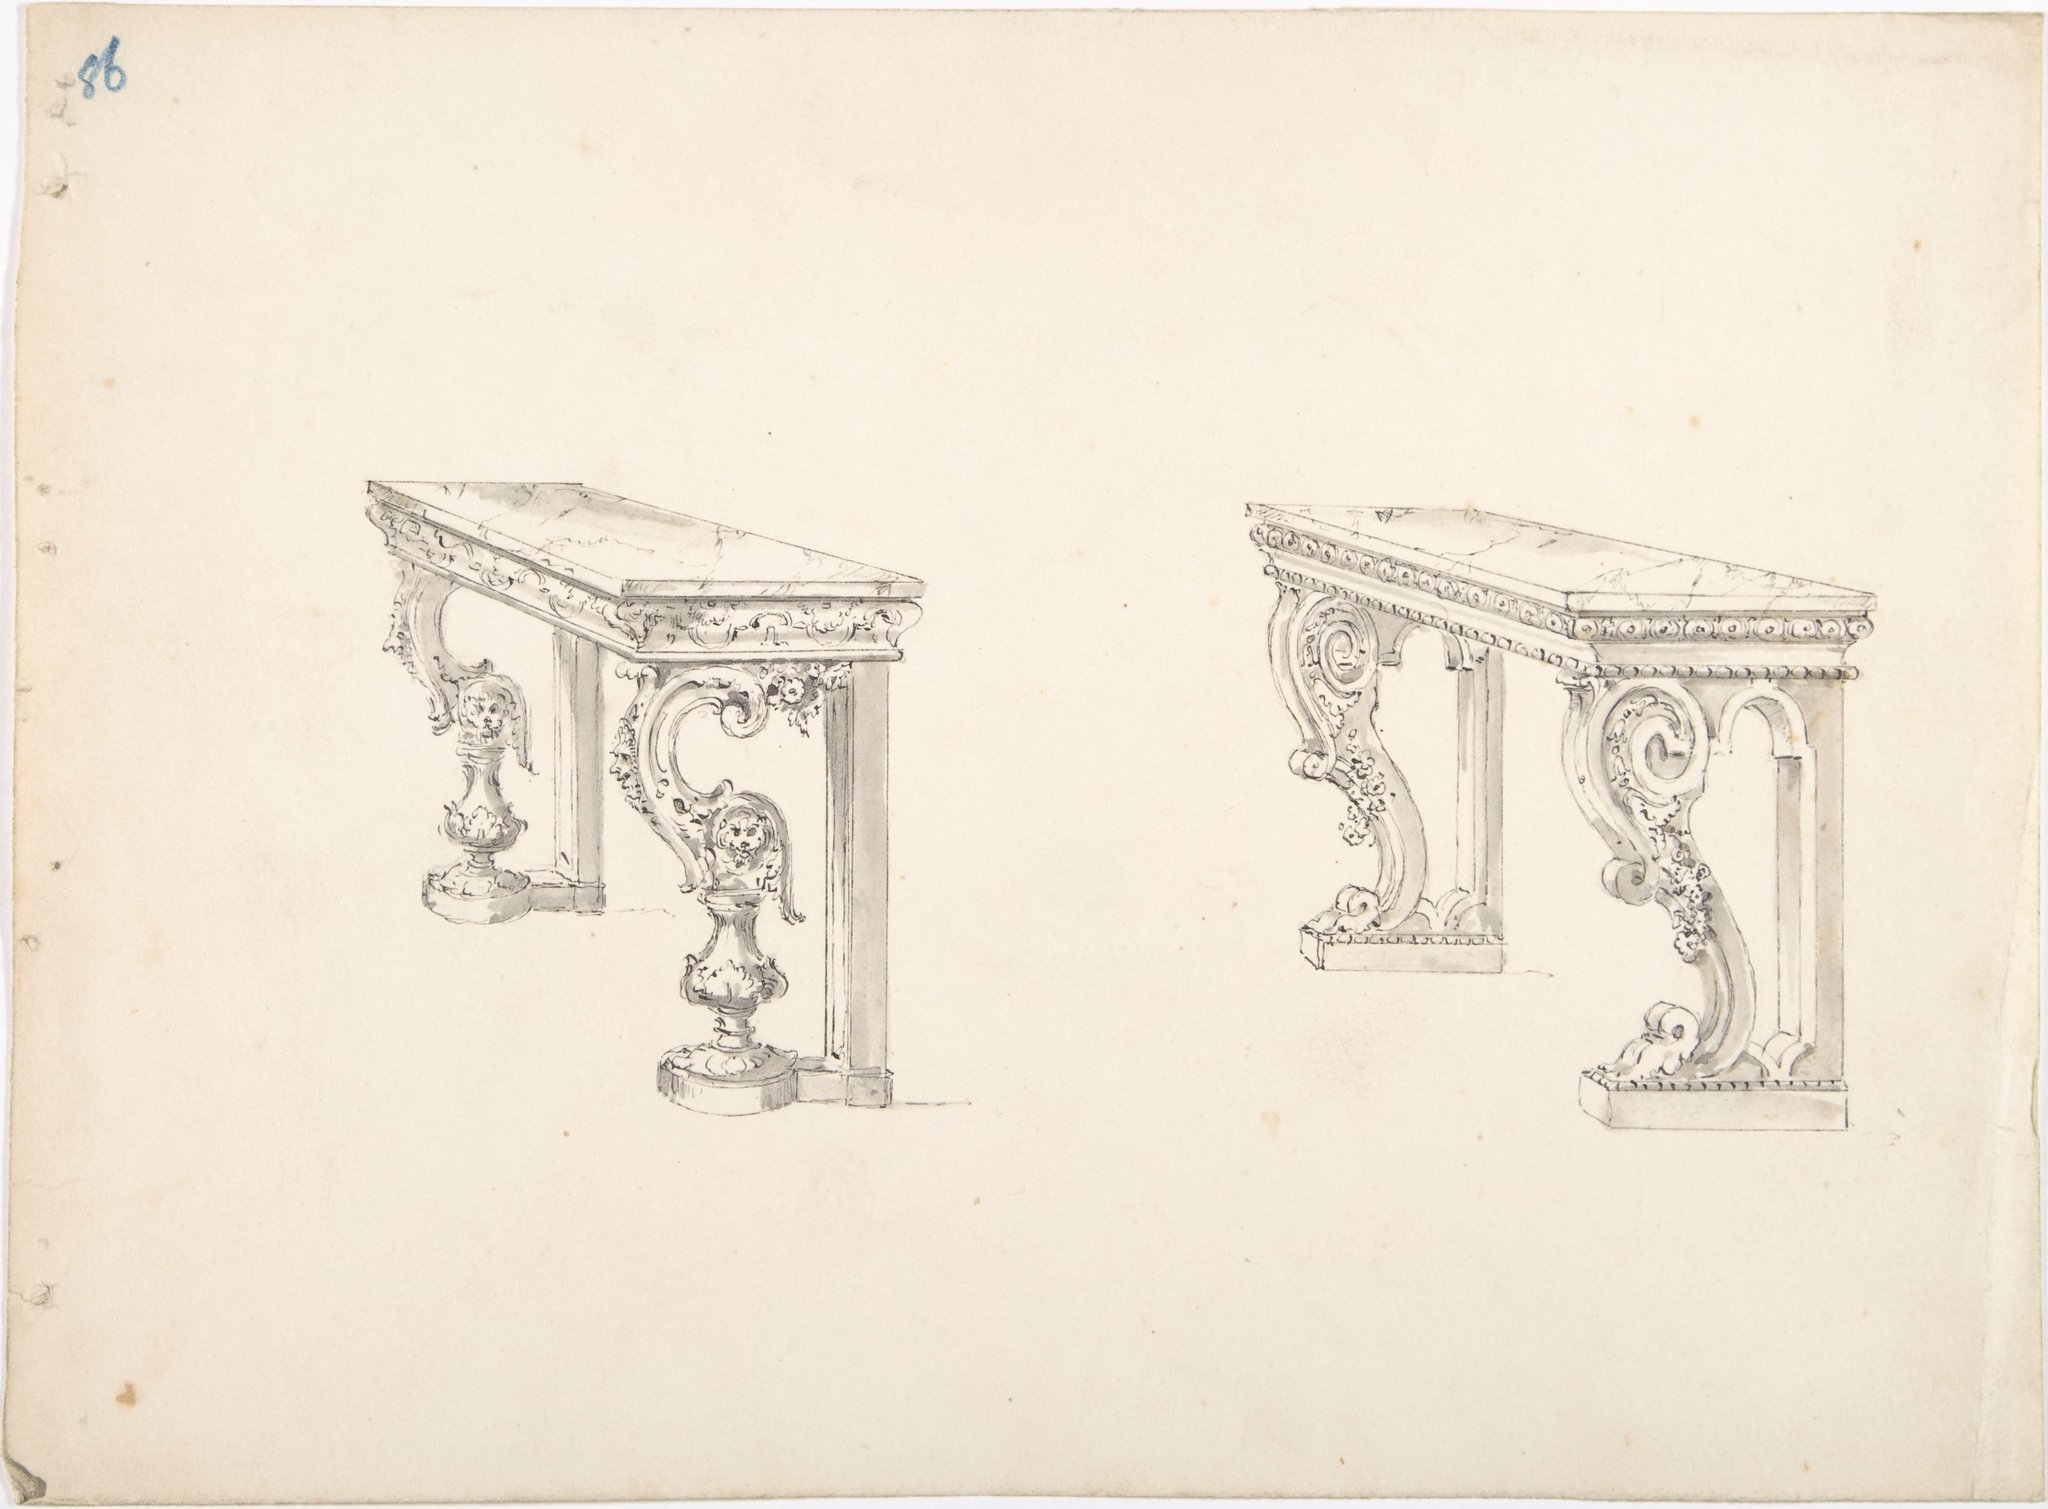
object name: drawing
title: Design for Two Marble-topped Pier Tables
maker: anonymous, british, 19th century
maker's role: artist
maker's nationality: british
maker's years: 1800-1900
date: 1801-1833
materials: ink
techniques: brush, pen, wash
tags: tables